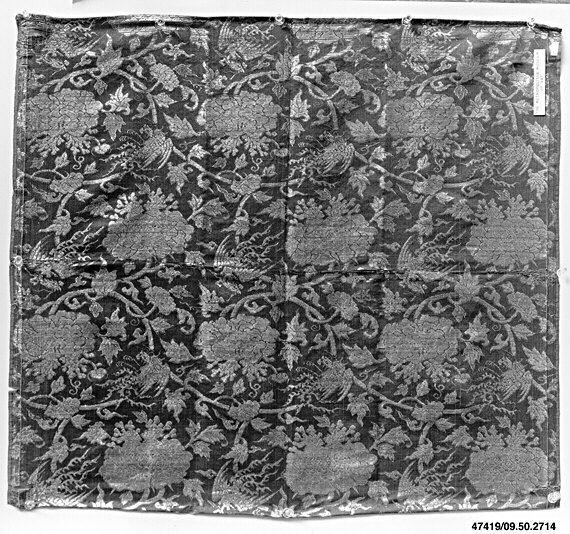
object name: altar cloth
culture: japanese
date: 1701-1800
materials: silk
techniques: brocade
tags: flowers